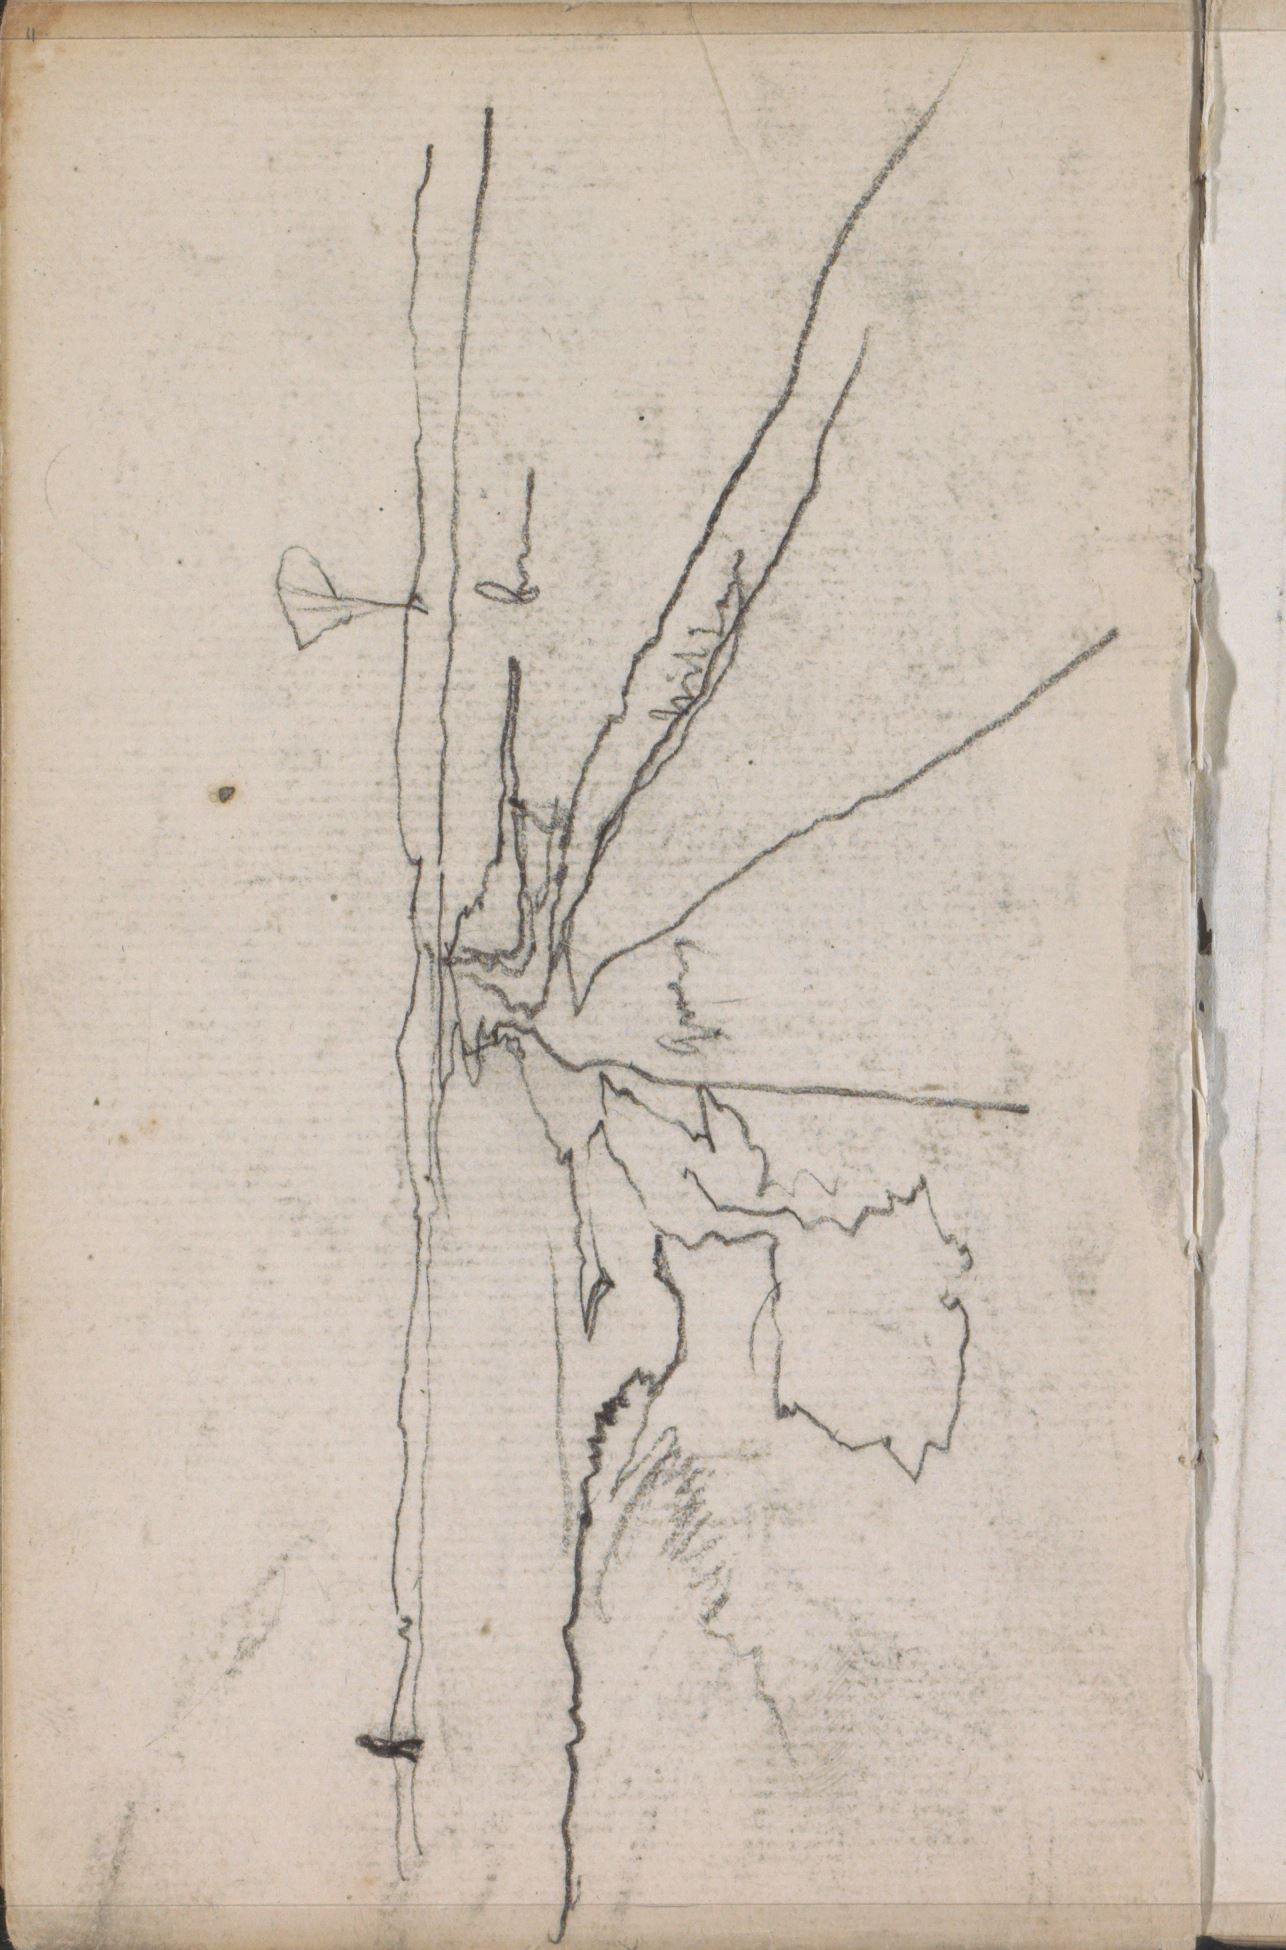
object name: sketchbook leaf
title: Landschap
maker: george hendrik breitner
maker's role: draughtsman, painter, print maker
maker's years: 1857-1923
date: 1884-1886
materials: chalk, paper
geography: drenthe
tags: landscapes (+ landscape with figures, staffage)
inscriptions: kleurnotitie, handgeschreven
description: In de verte een figuur. Pagina 11 uit een schetsboek met 67 bladen vervaardigd in Drenthe.